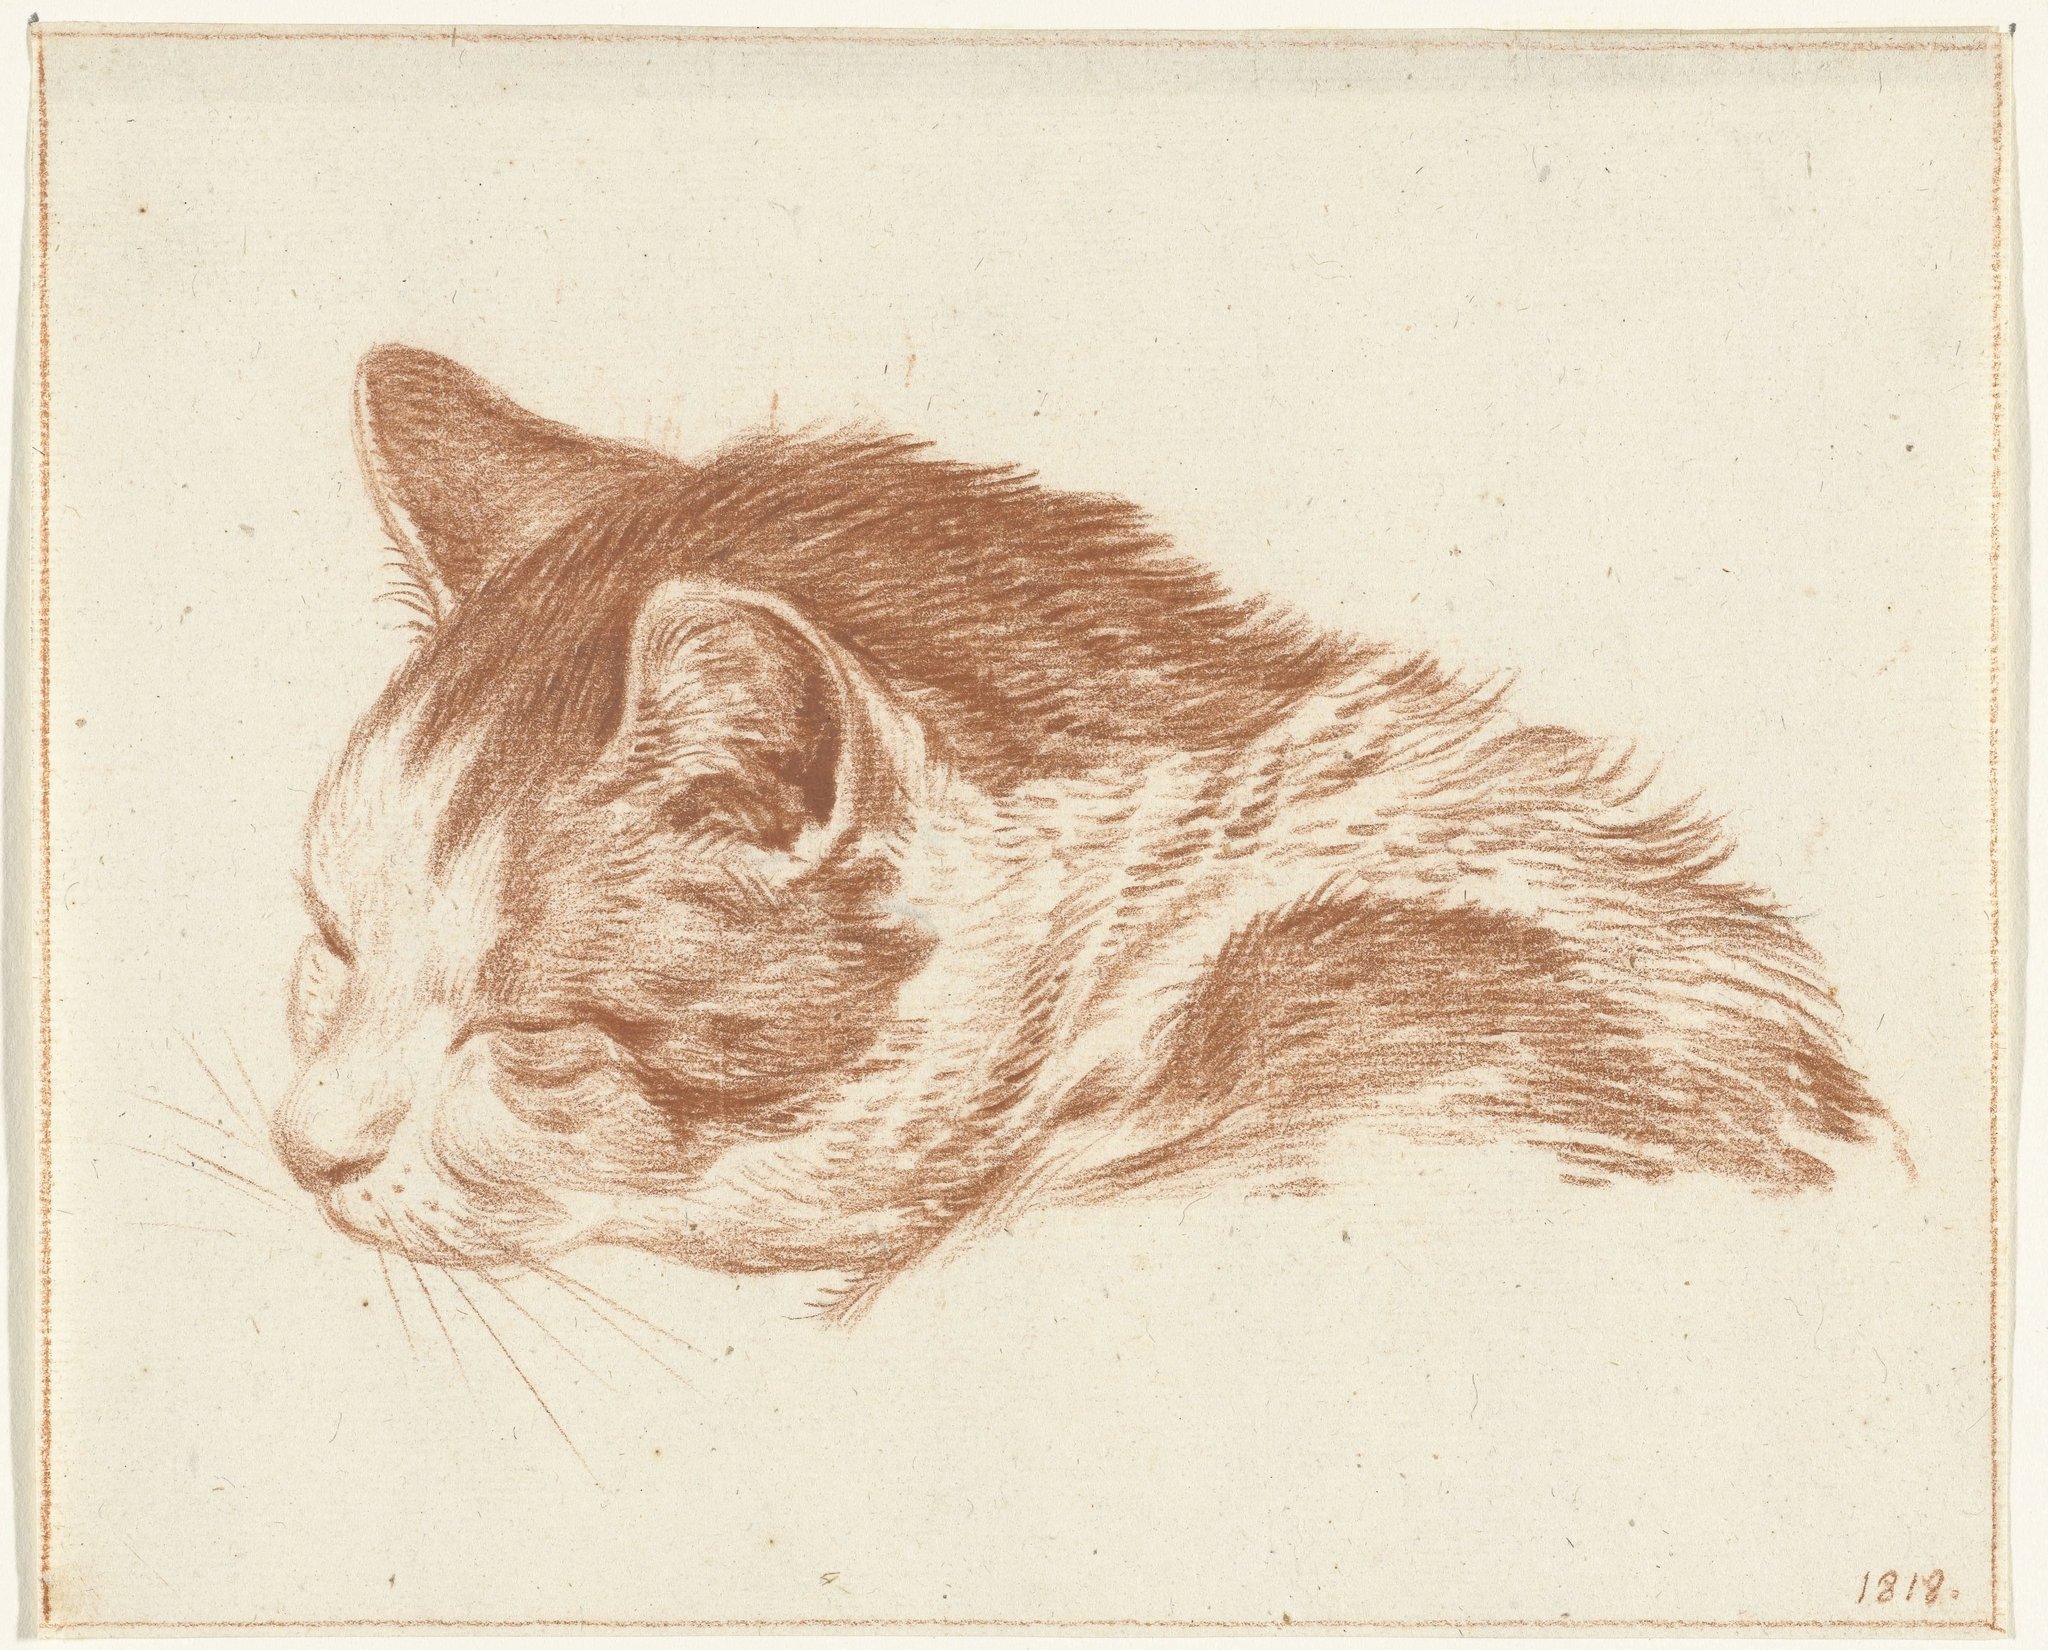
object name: drawing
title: Kop van een slapende kat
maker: jean bernard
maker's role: draughtsman, print maker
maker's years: 1765-1833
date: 1818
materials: chalk, paper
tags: cat